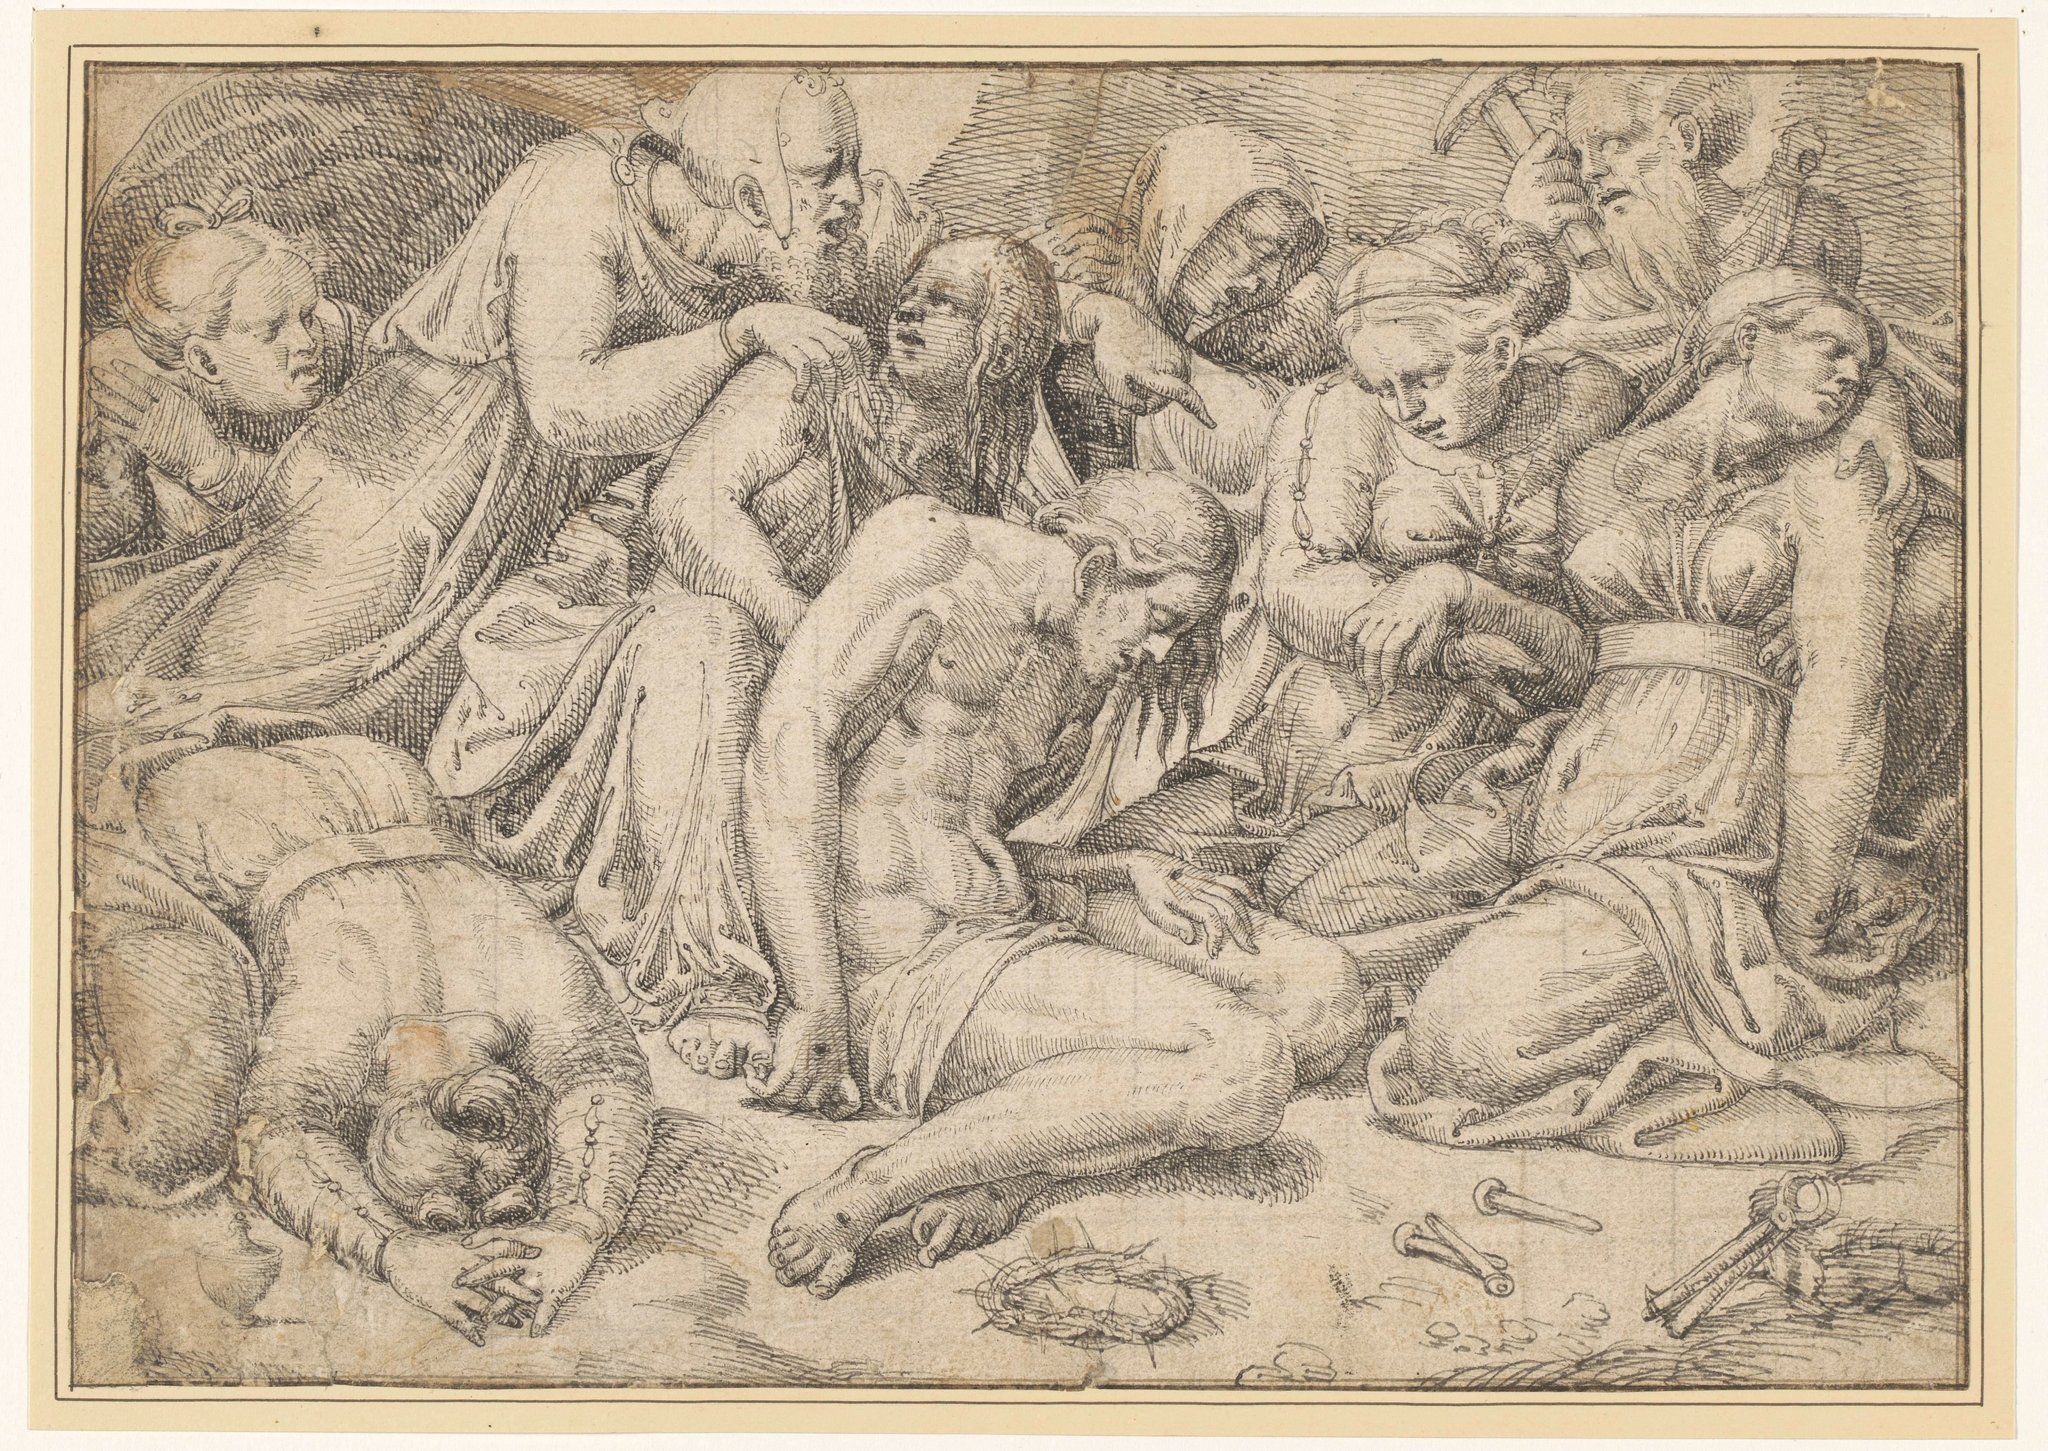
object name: drawing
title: The Lamentation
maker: jan cornelisz vermeyen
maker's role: draughtsman, painter, print maker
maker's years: 1500-1559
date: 1532-1535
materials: paper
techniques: pen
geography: antwerp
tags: christ's body lying on the ground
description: This drawing has all the drama of a medieval passion play. The contrast between the limp, broken body of Christ and the emotional turmoil of the other figures is heart-rending. With its dense parallel and crosshatching, the drawing style lends itself for comparison with Vermeyen’s etchings. The drawing has been squared for transfer (overmarked with a grid), suggesting that it is a design for a painting.